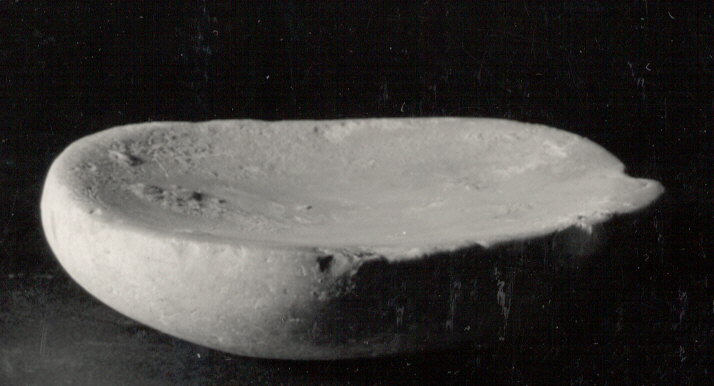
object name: mortar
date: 7000-5001 BCE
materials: limestone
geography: syria